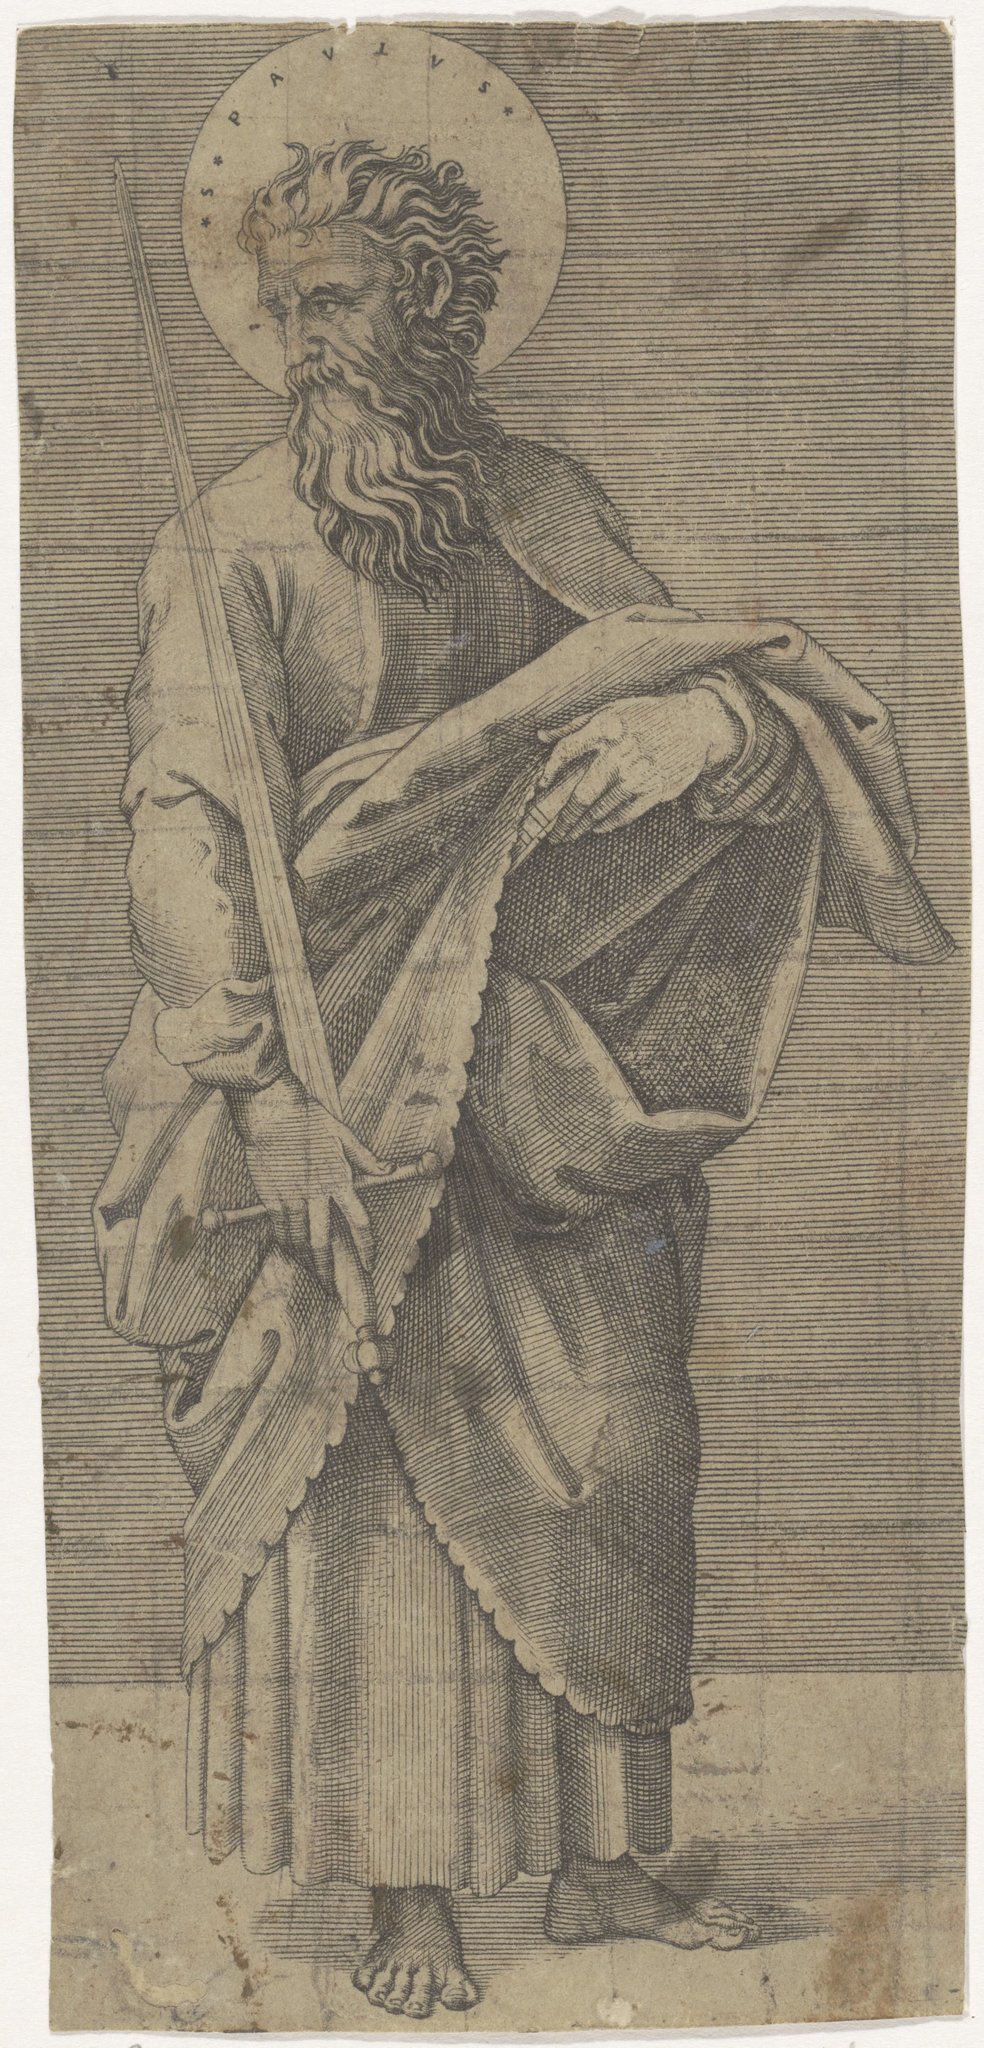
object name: print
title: Christus en de Apostelen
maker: marcantonio raimondi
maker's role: print maker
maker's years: 1470-1534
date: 1517-1527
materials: paper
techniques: engraving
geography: italy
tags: the apostle paul of tarsus; possible attributes: book, scroll, sword